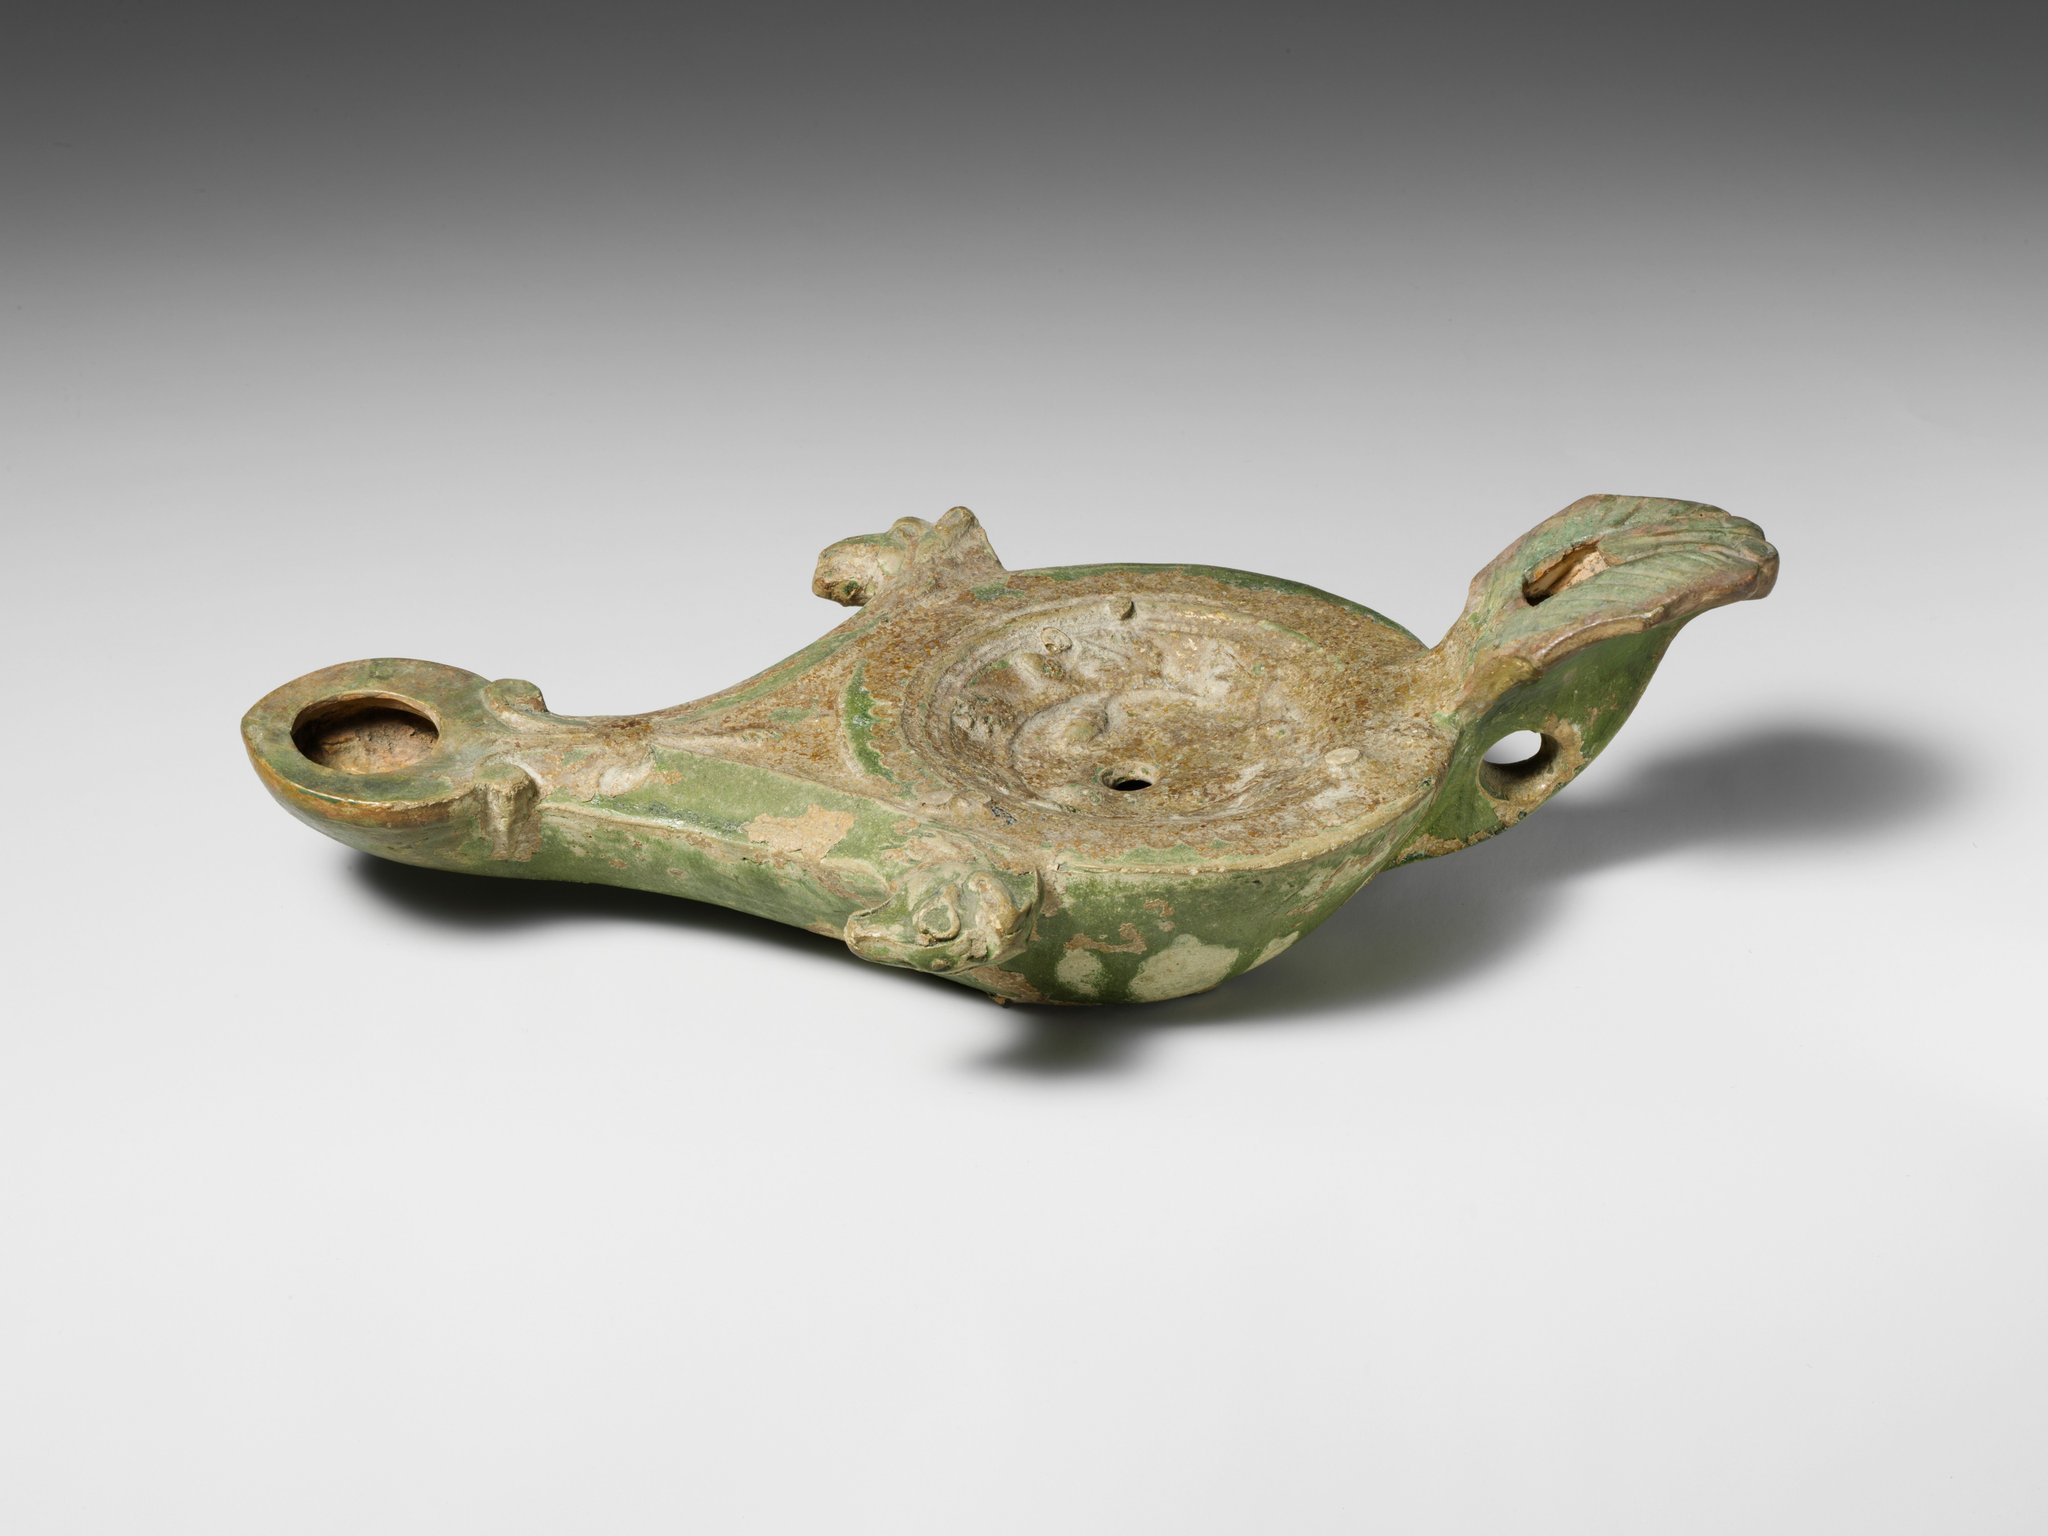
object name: lamp, glazed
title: Terracotta oil lamp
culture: roman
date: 67-133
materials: terracotta